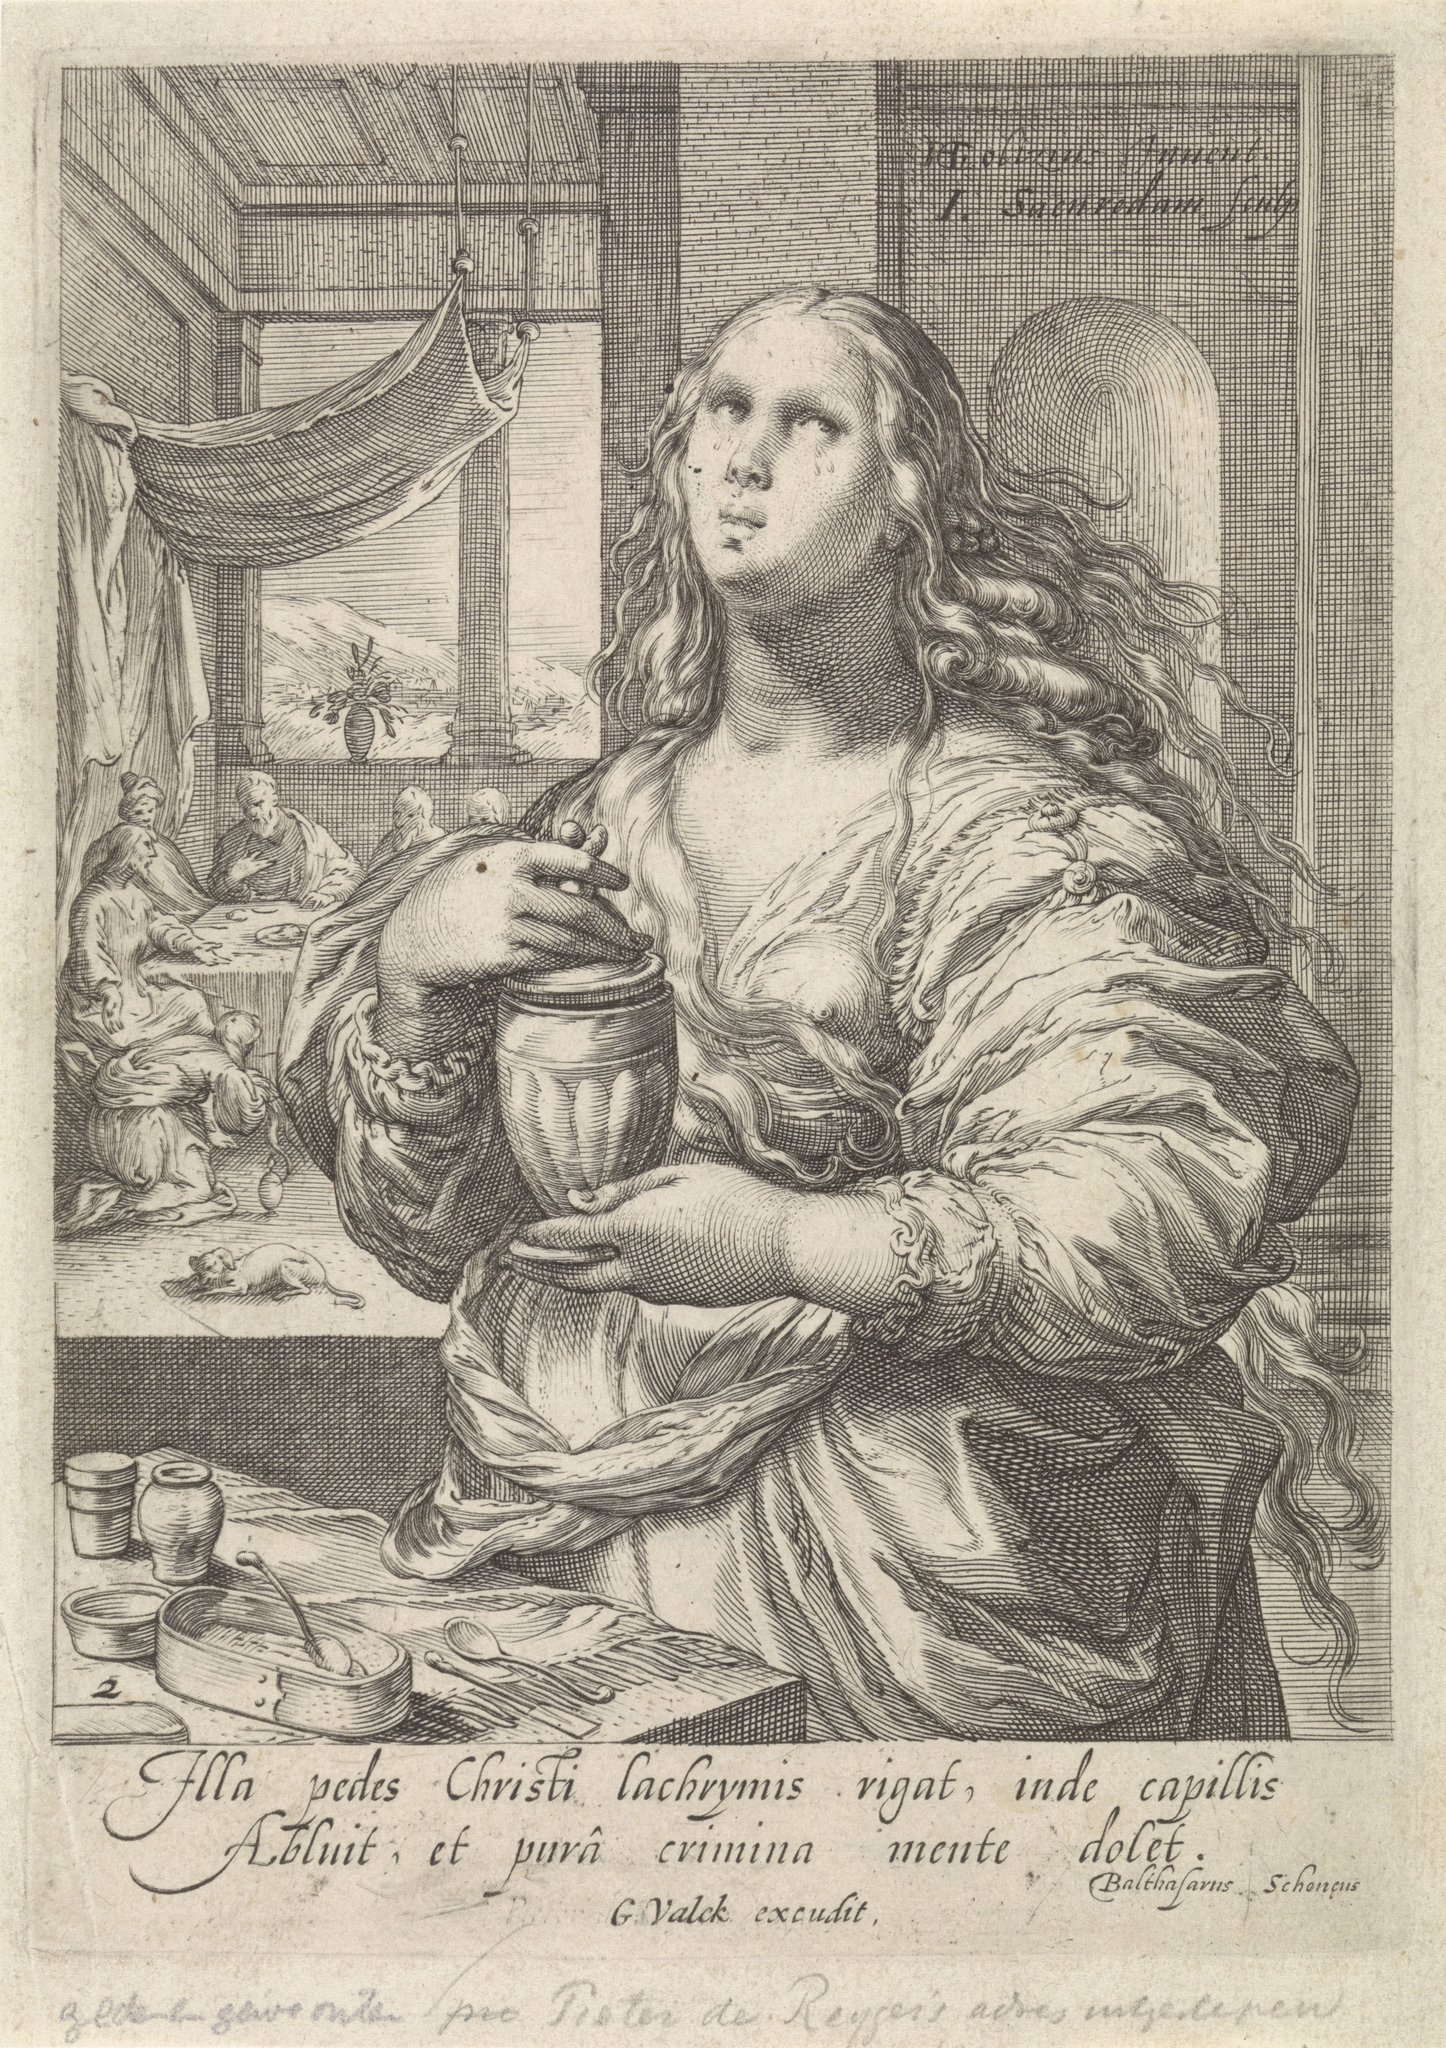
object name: print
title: Maria Magdalena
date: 1661-1726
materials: paper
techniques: engraving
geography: amsterdam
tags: christ's feet are anointed by mary (magdalene), the penitent harlot mary magdalene; possible attributes: book (or scroll), crown, crown of thorns, crucifix, jar of ointment, mirror, musical instrument, palm-branch, rosary, scourge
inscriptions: collector's mark: Lugt 2228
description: Op de voorgrond Maria Magdalena, in haar hand een kruik met balsemolie. Ze huilt. Op de achtergrond zalft Maria Magdalena de voeten van Christus wanneer hij te gast is bij Simon de Farizeeër. De prent heeft een Latijns onderschrift en maakt deel uit van een prentserie met beroemde vrouwen uit het Nieuwe Testament